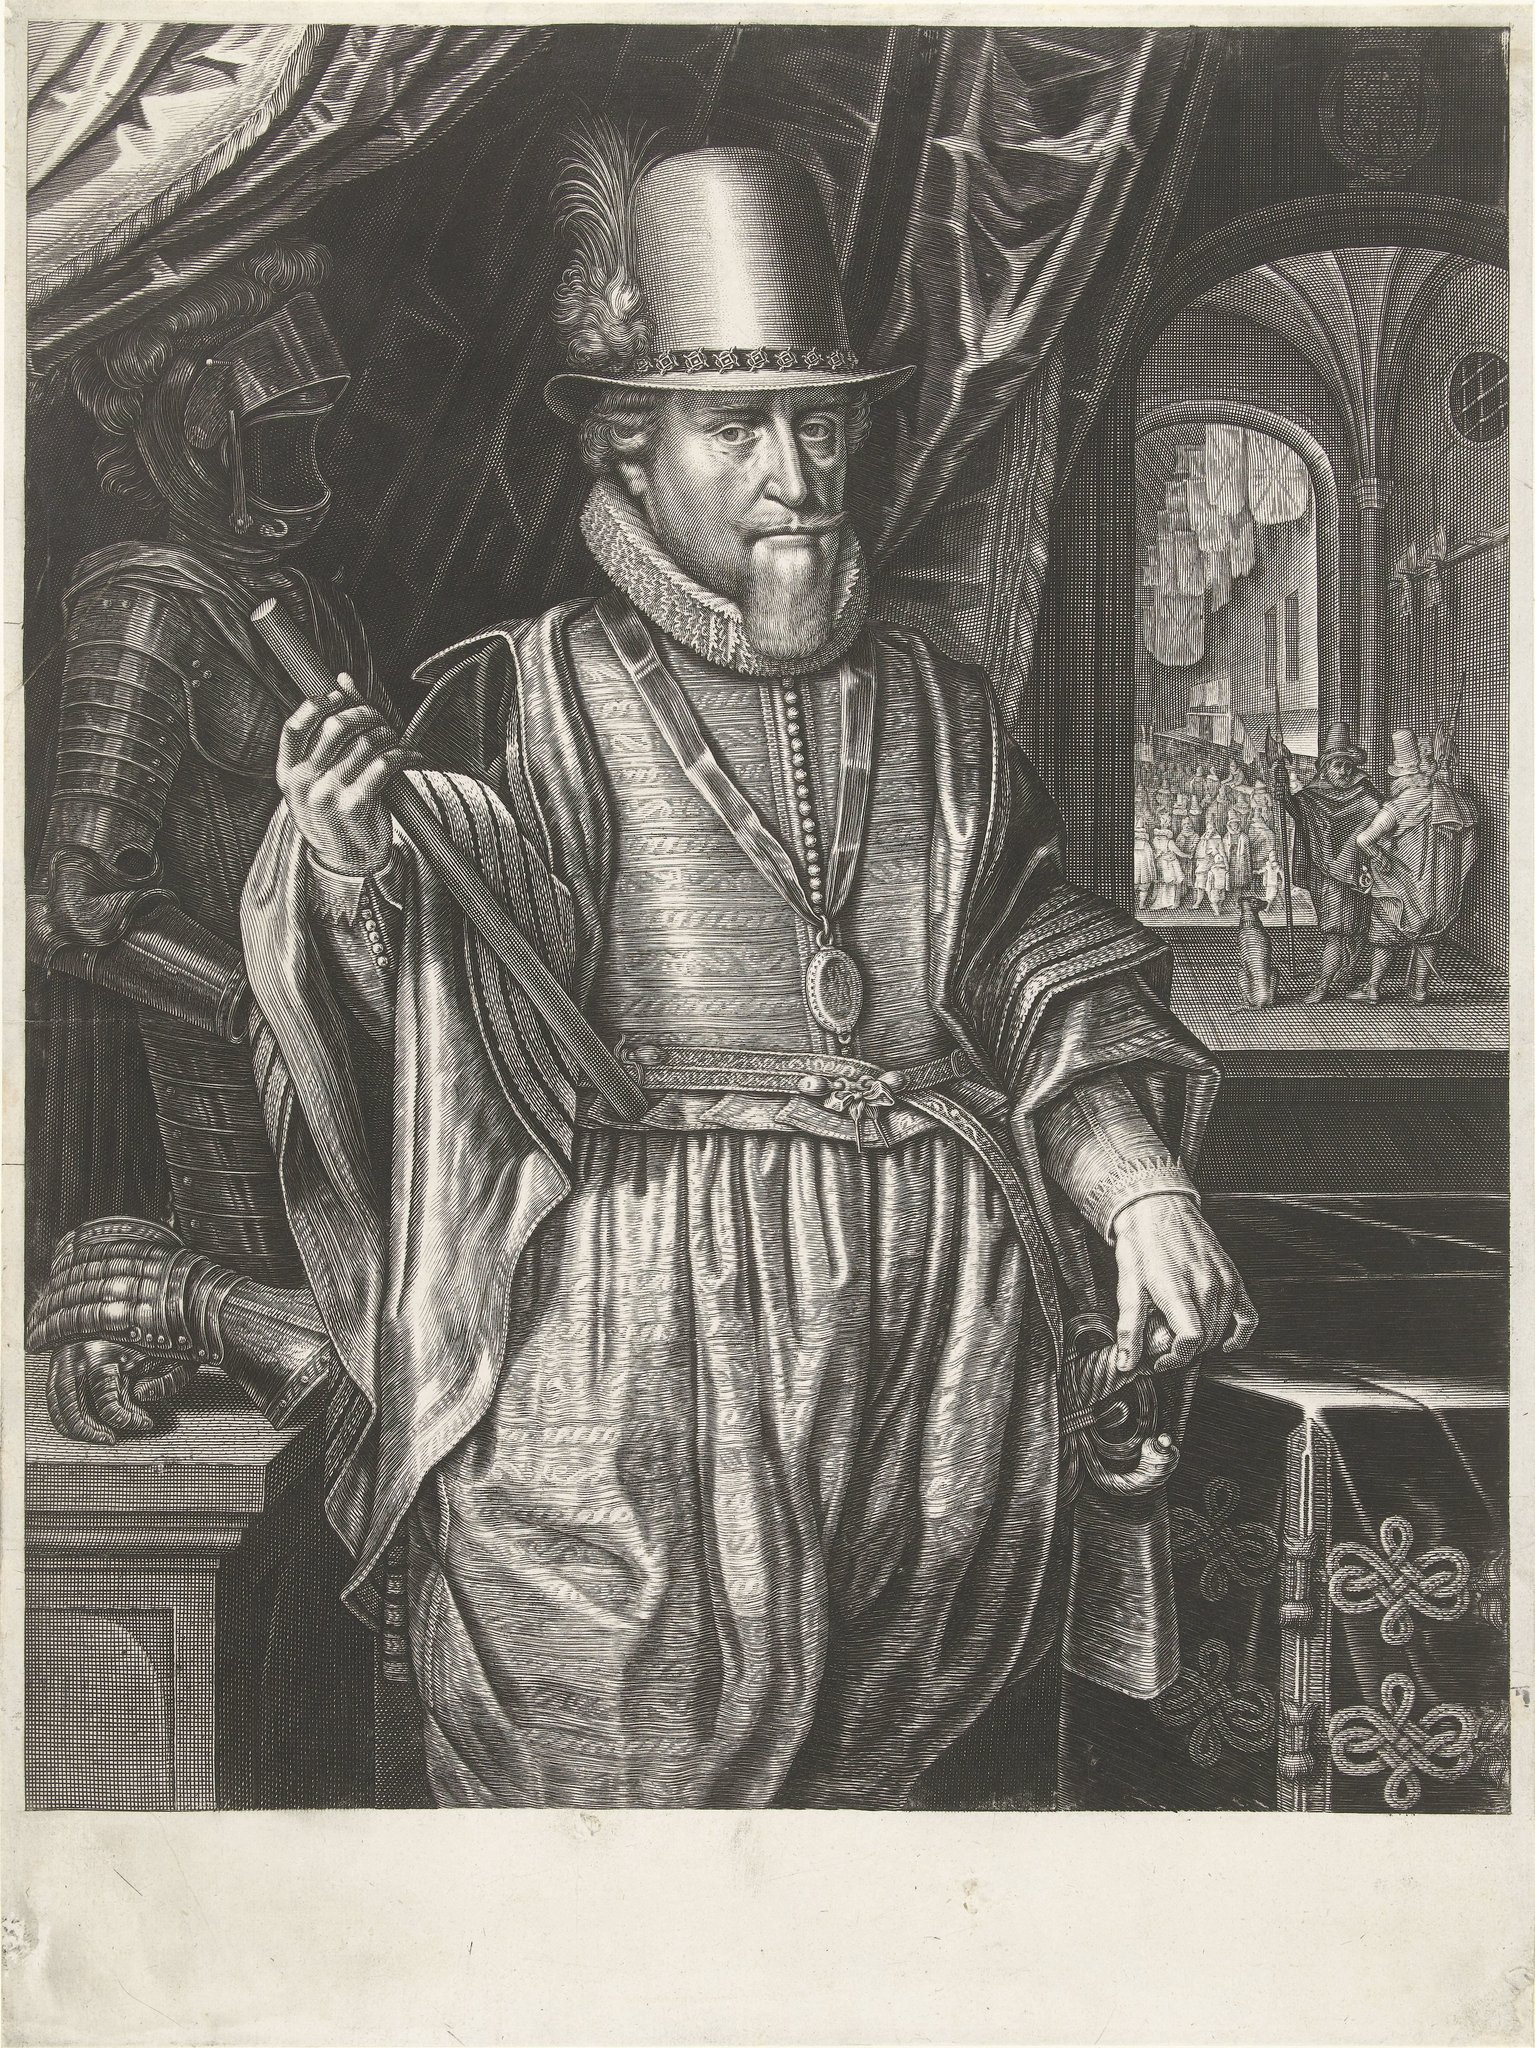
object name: print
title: Portret van Maurits, prins van Oranje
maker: willem jacobsz delff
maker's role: draughtsman, print maker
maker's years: 1580-1638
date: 1618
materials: paper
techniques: engraving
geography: delft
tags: maurice (prince of orange)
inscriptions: collector's mark: Lugt 2228, collector's mark: Lugt 130, collector's mark: Lugt 2760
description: Portret van Maurits, prins van Oranje, staand in een interieur met commadostaf in rechterhand. Rechts een doorkijkje, mogelijk het interieur van de Ridderzaal.